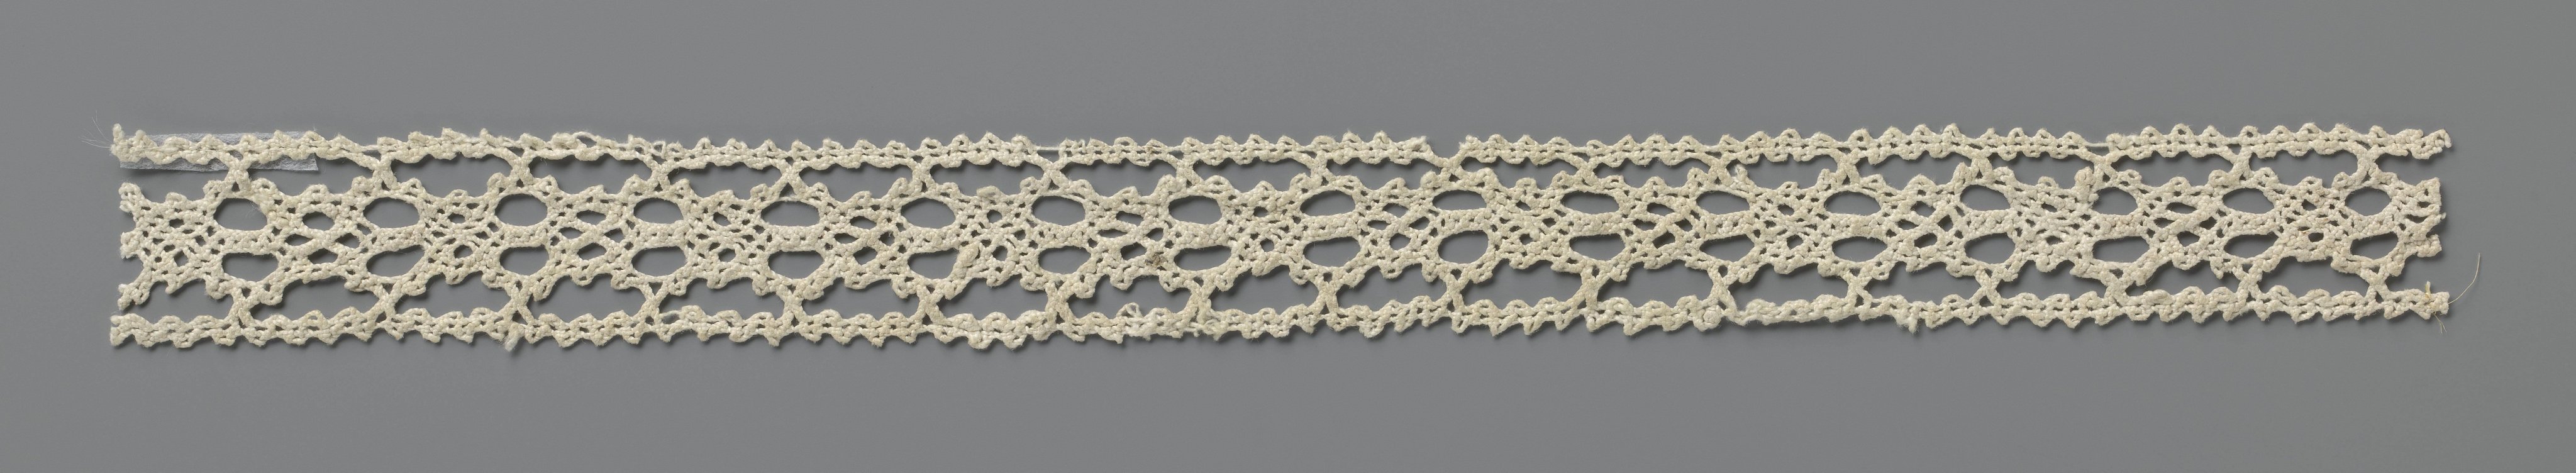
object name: strip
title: Strook of tussenzetsel van kloskant met cirkelvormige motiefjes en dubbel ovale uitsparingen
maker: Anonymous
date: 1550-1599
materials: linen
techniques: lace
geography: italy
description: Strook naturelkleurige kloskant. Het zich herhalende en symmetrische patroon wordt gevormd door een open netwerk van vlechten, gemaakt met een relatief grove draad. Het bestaat uit een keten van cirkelvormige motiefjes, gevuld met een X of fijnere mazen. De cirkels zijn met elkaar verbonden door dubbele, boven elkaar geplaatste ovalen zonder vulling. Boven- en onderzijde van de strook zijn recht afgewerkt. De keten met motiefjes is hieraan met X-vormig gekruiste vlechtjes verbonden, steeds onder de dubbele ovale uitsparingen.